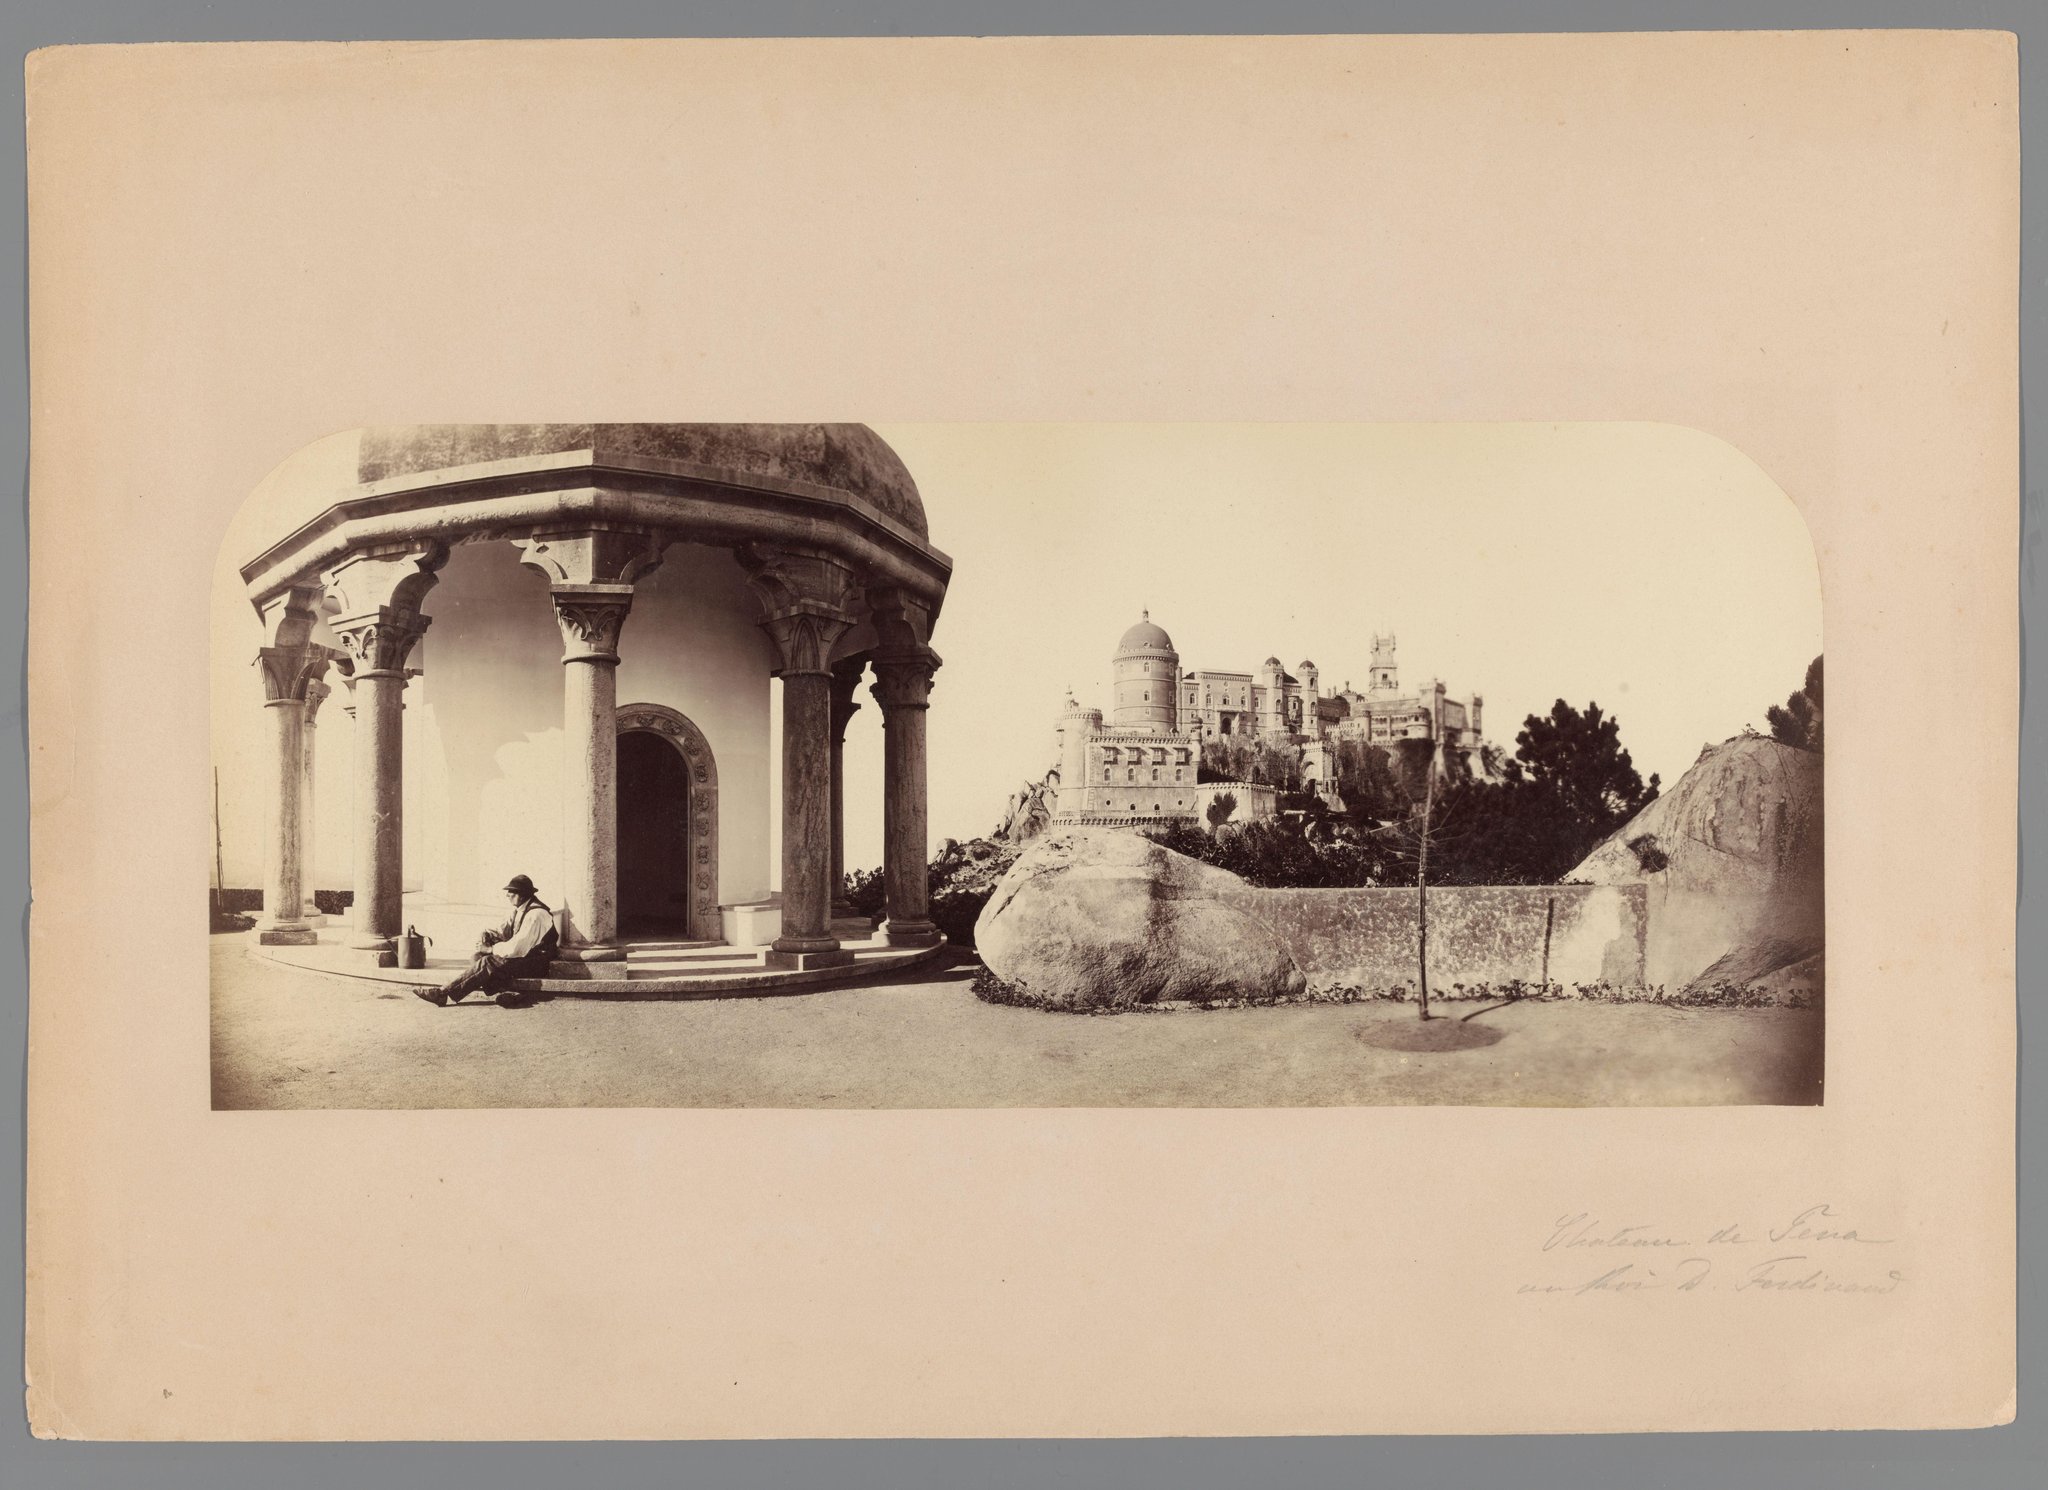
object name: photograph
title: Panoramafoto van het Château de Pena du Roi Ferdinand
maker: Anonymous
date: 1870-1890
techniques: albumen print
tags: palácio da pena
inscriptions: inscription: ‘Palacio National de Pena’